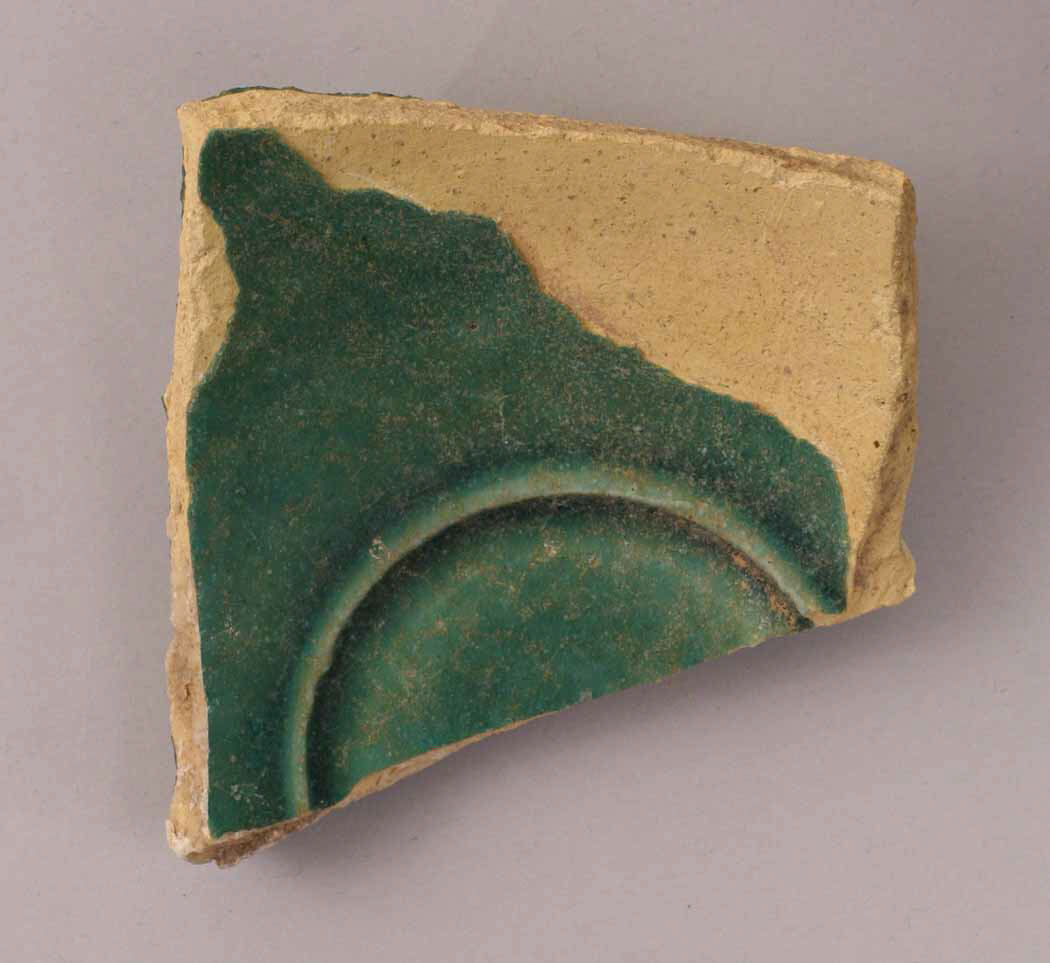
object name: fragment of a bowl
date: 801-900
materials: earthenware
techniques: glazing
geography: iraq